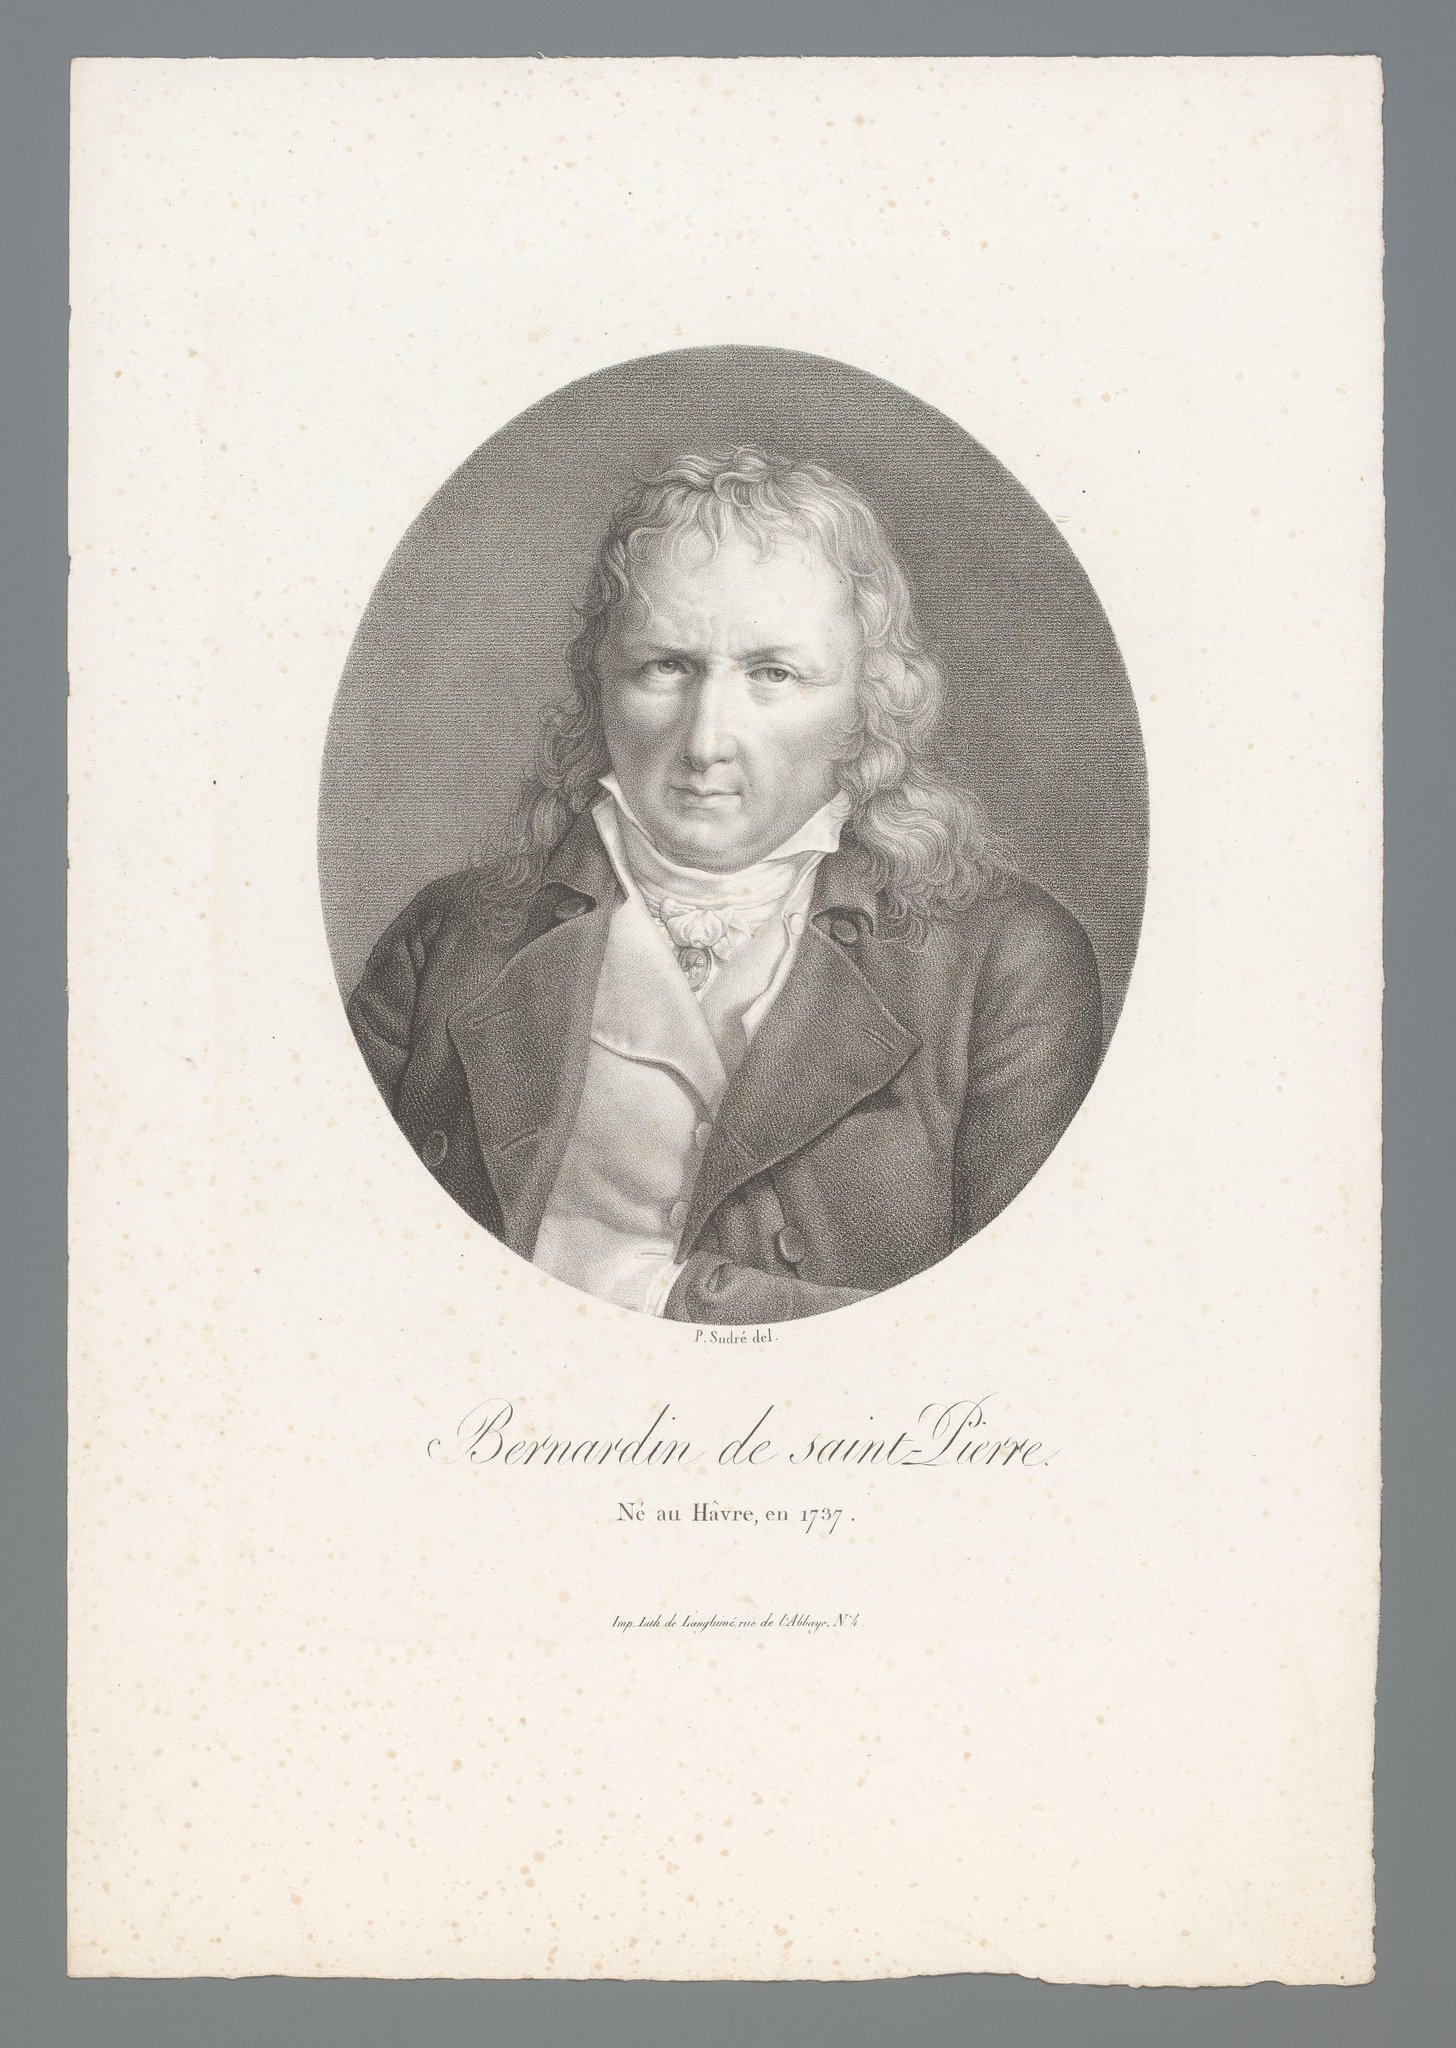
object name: print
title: Bernardin de saint-Pierre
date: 1822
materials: paper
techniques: lithograph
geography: paris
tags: historical persons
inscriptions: collector's mark: Lugt 2228